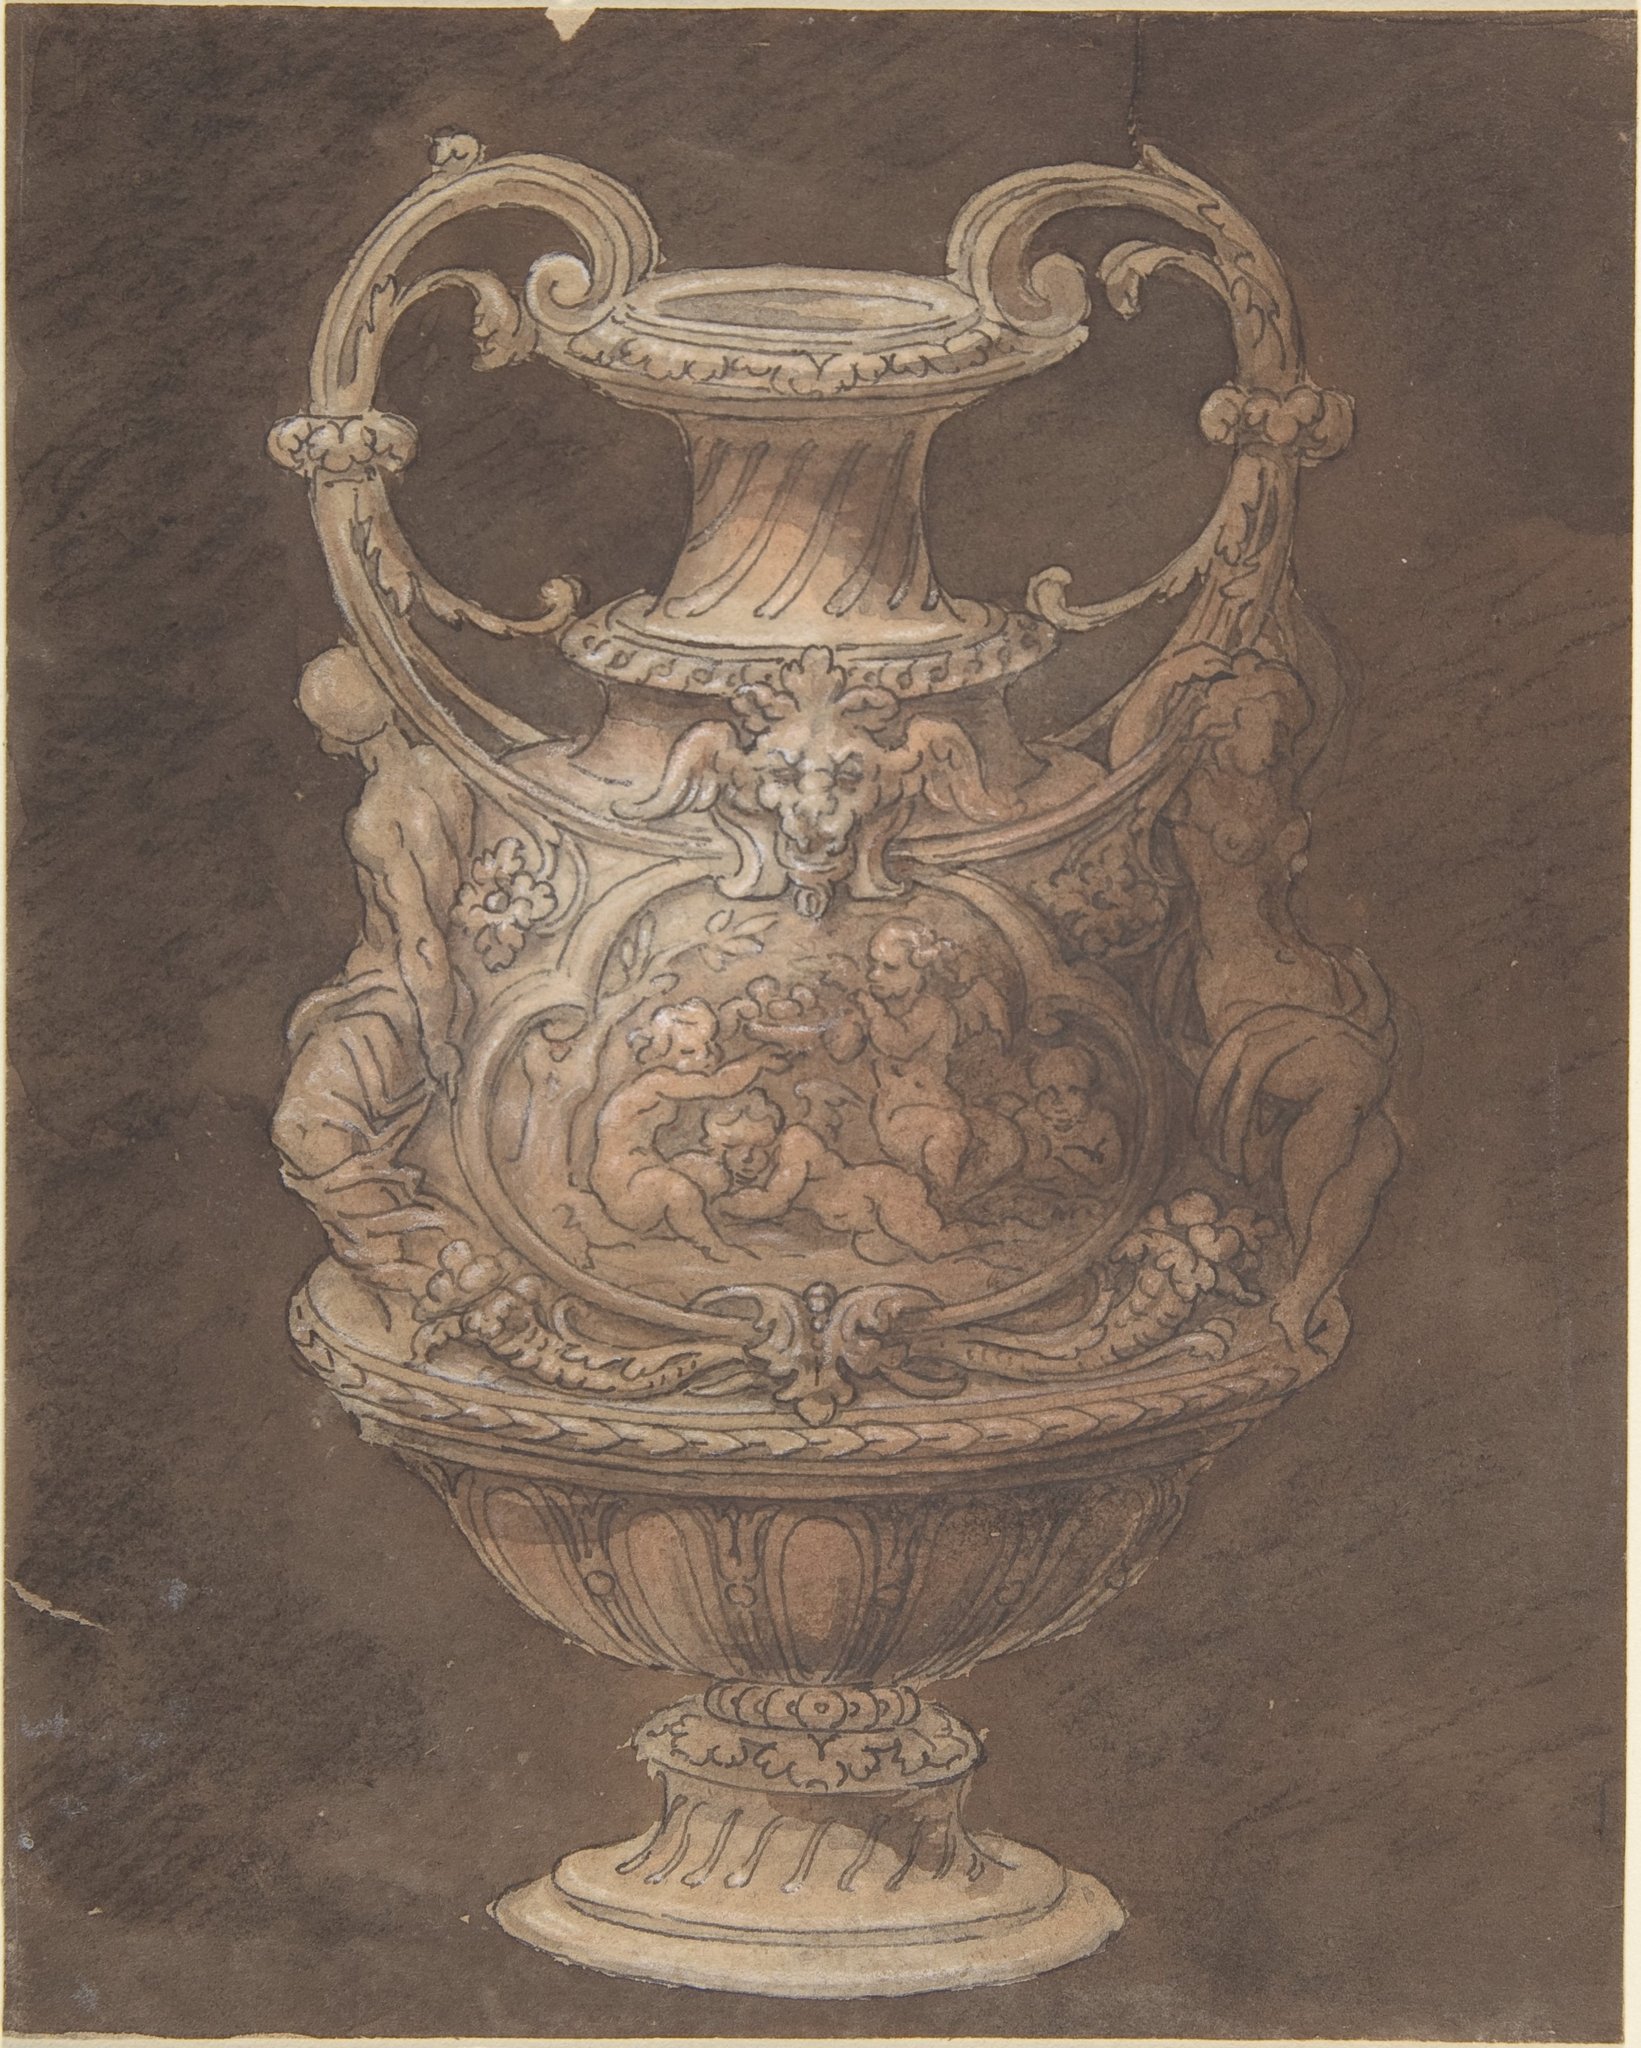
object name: drawing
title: Design for an Urn with Four Putti in Central Cartouche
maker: anonymous, italian, early 19th century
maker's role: artist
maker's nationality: italian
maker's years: 1800-1825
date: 1810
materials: ink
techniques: pen, wash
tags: cupid,urns